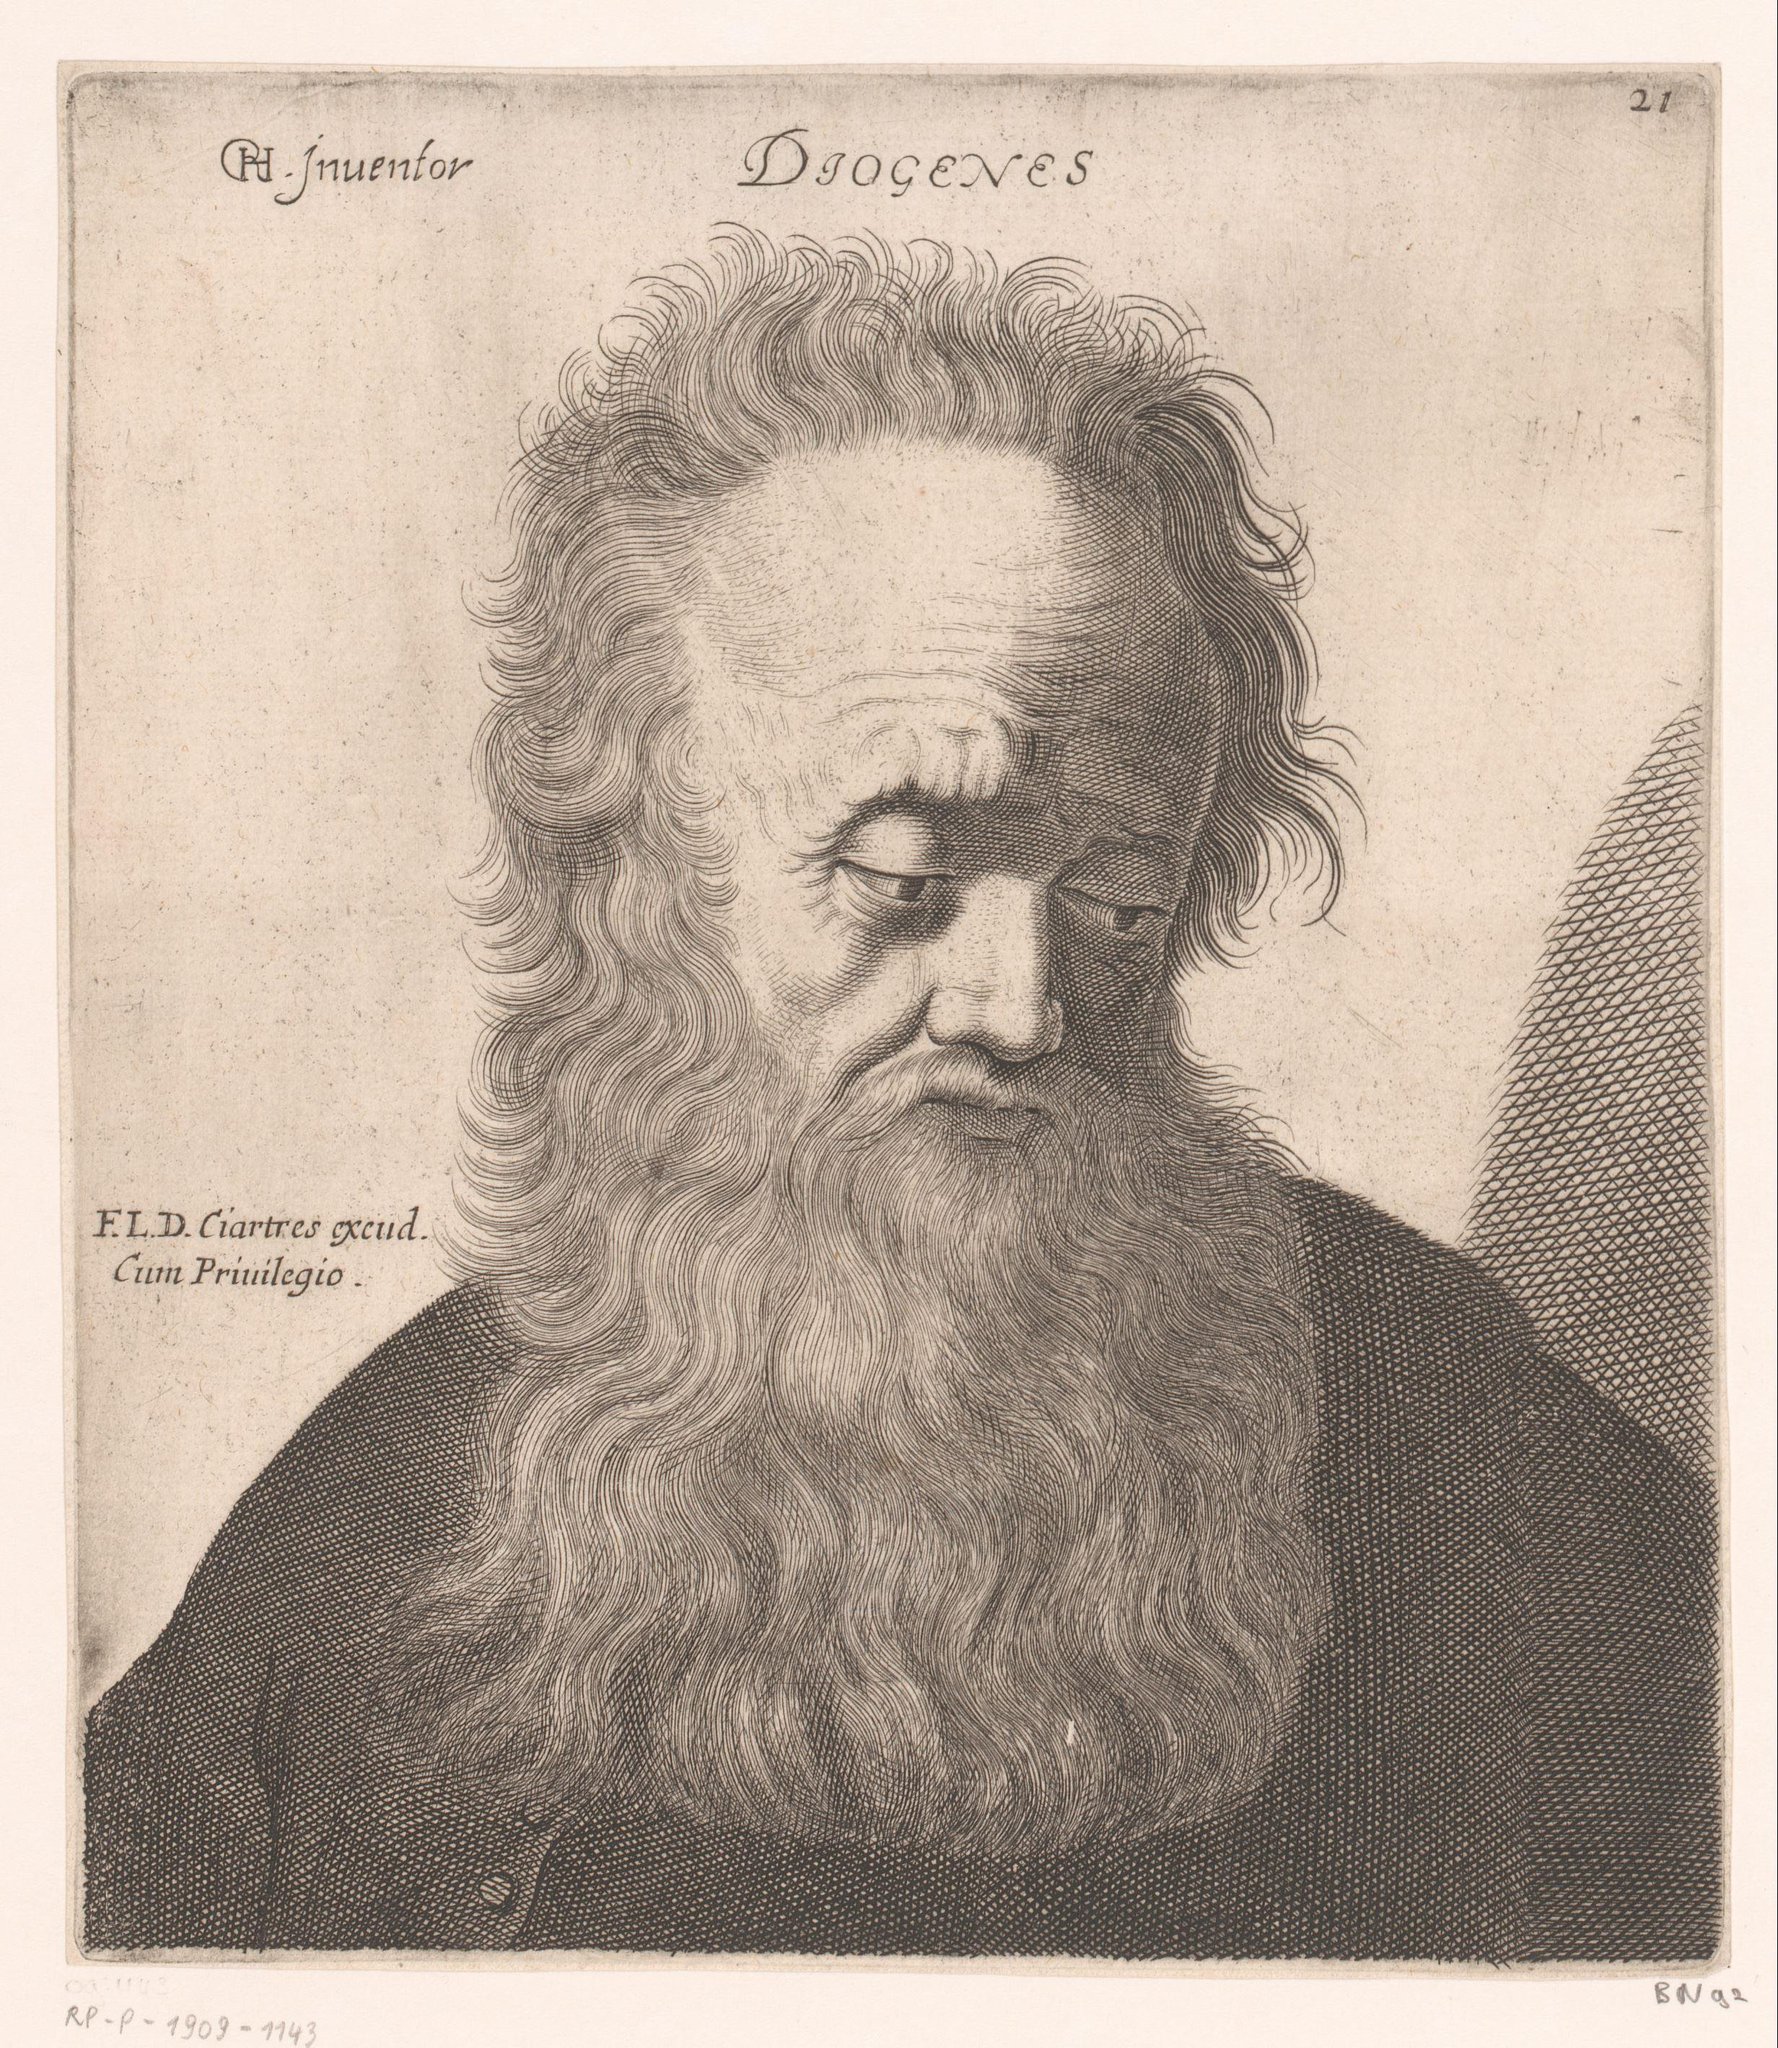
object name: print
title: Diogenes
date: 1615-1647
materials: paper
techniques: engraving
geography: paris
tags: scholar, philosopher, historical persons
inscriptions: collector's mark: Lugt 2228